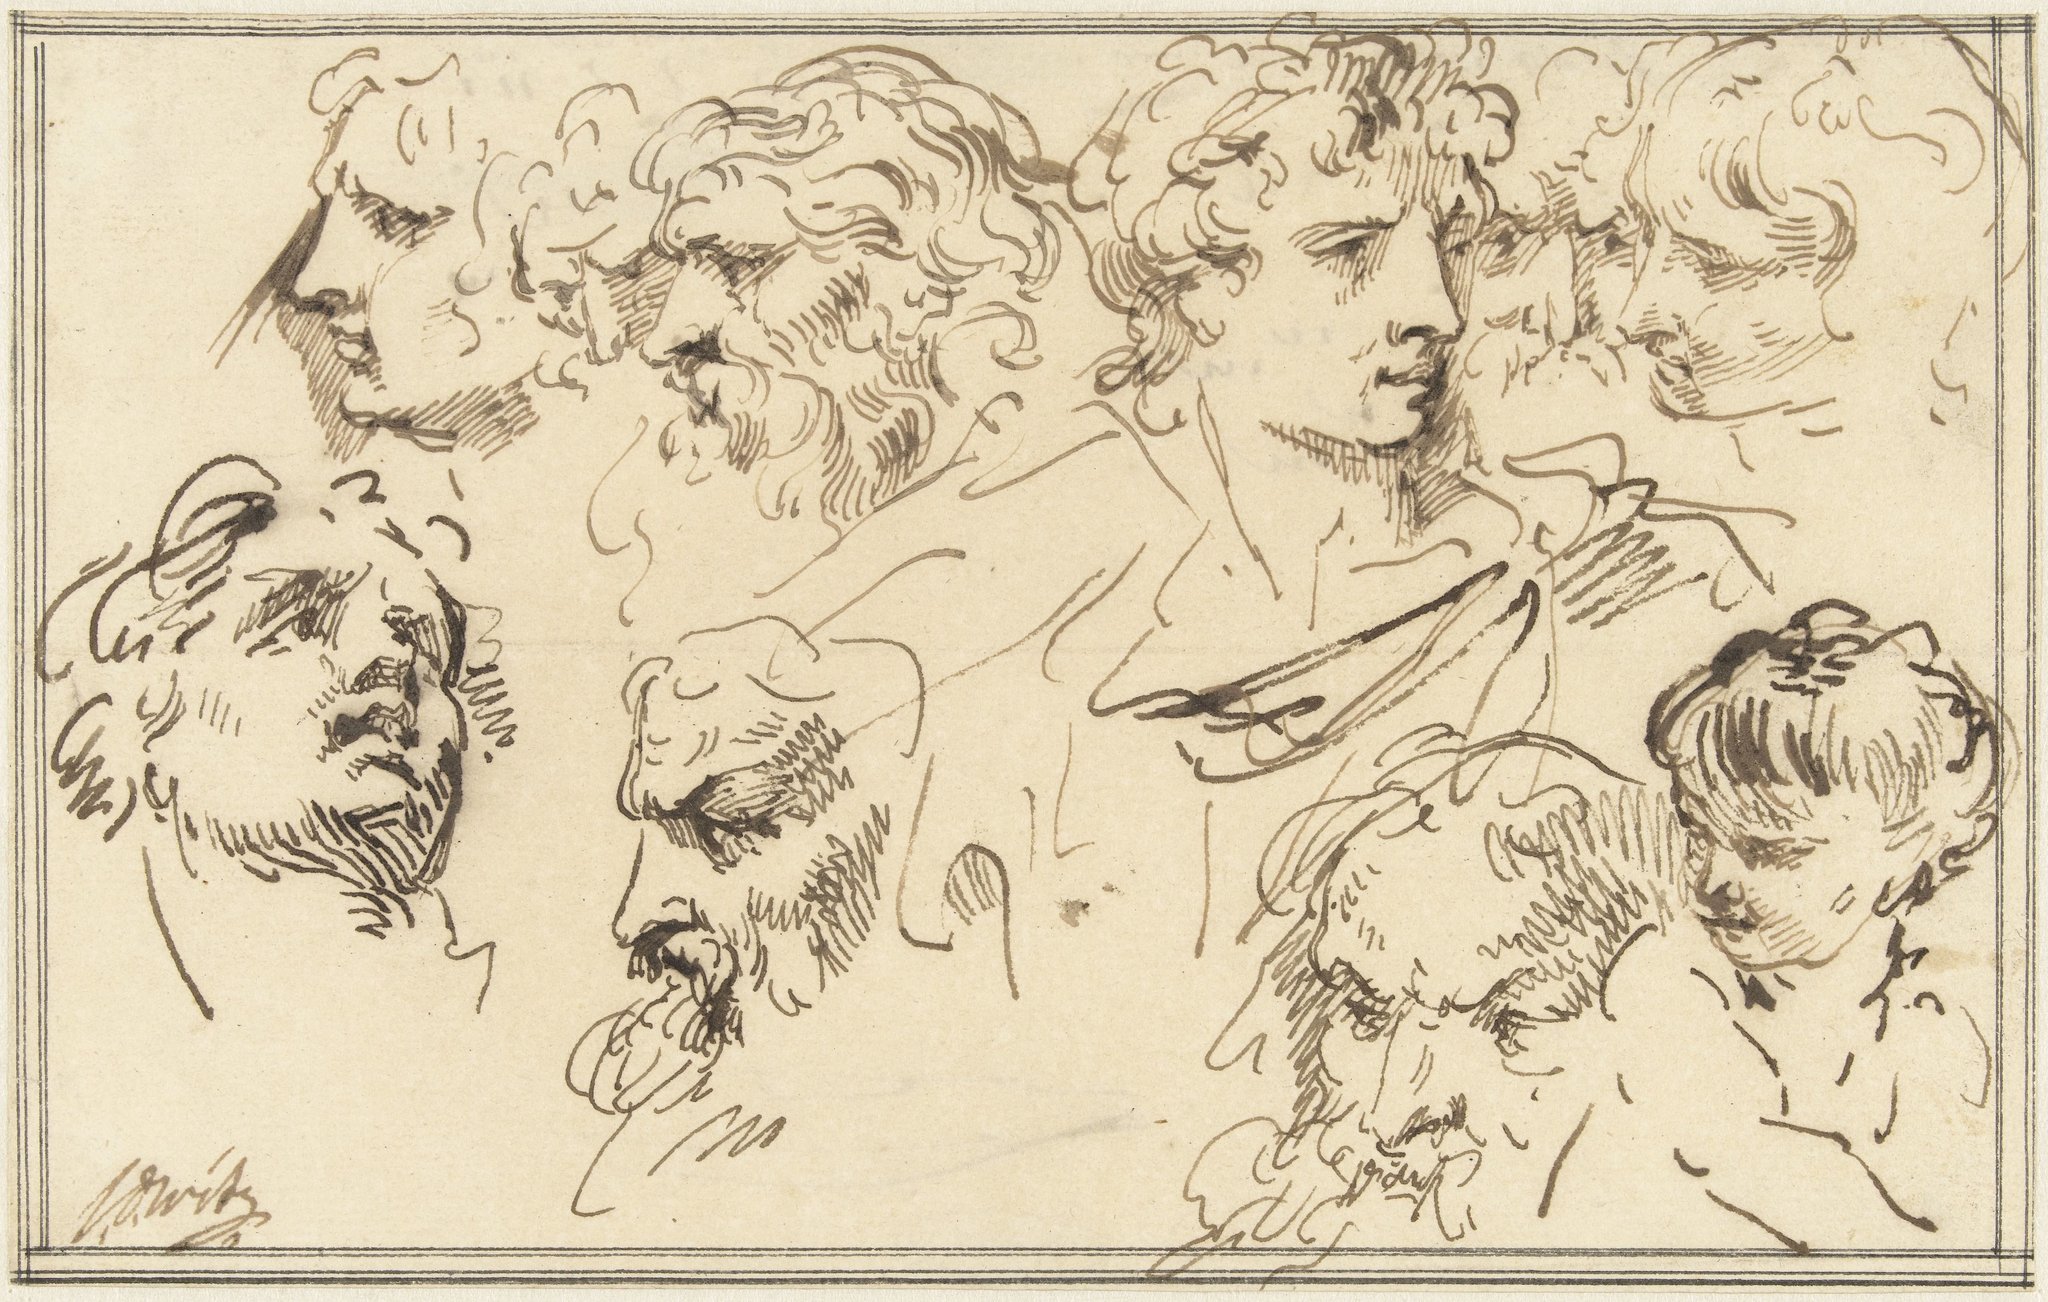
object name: drawing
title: Studieblad met tien koppen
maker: jacob de wit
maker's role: draughtsman, painter, print maker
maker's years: 1695-1754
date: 1705-1754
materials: ink, paper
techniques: pen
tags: head (human)